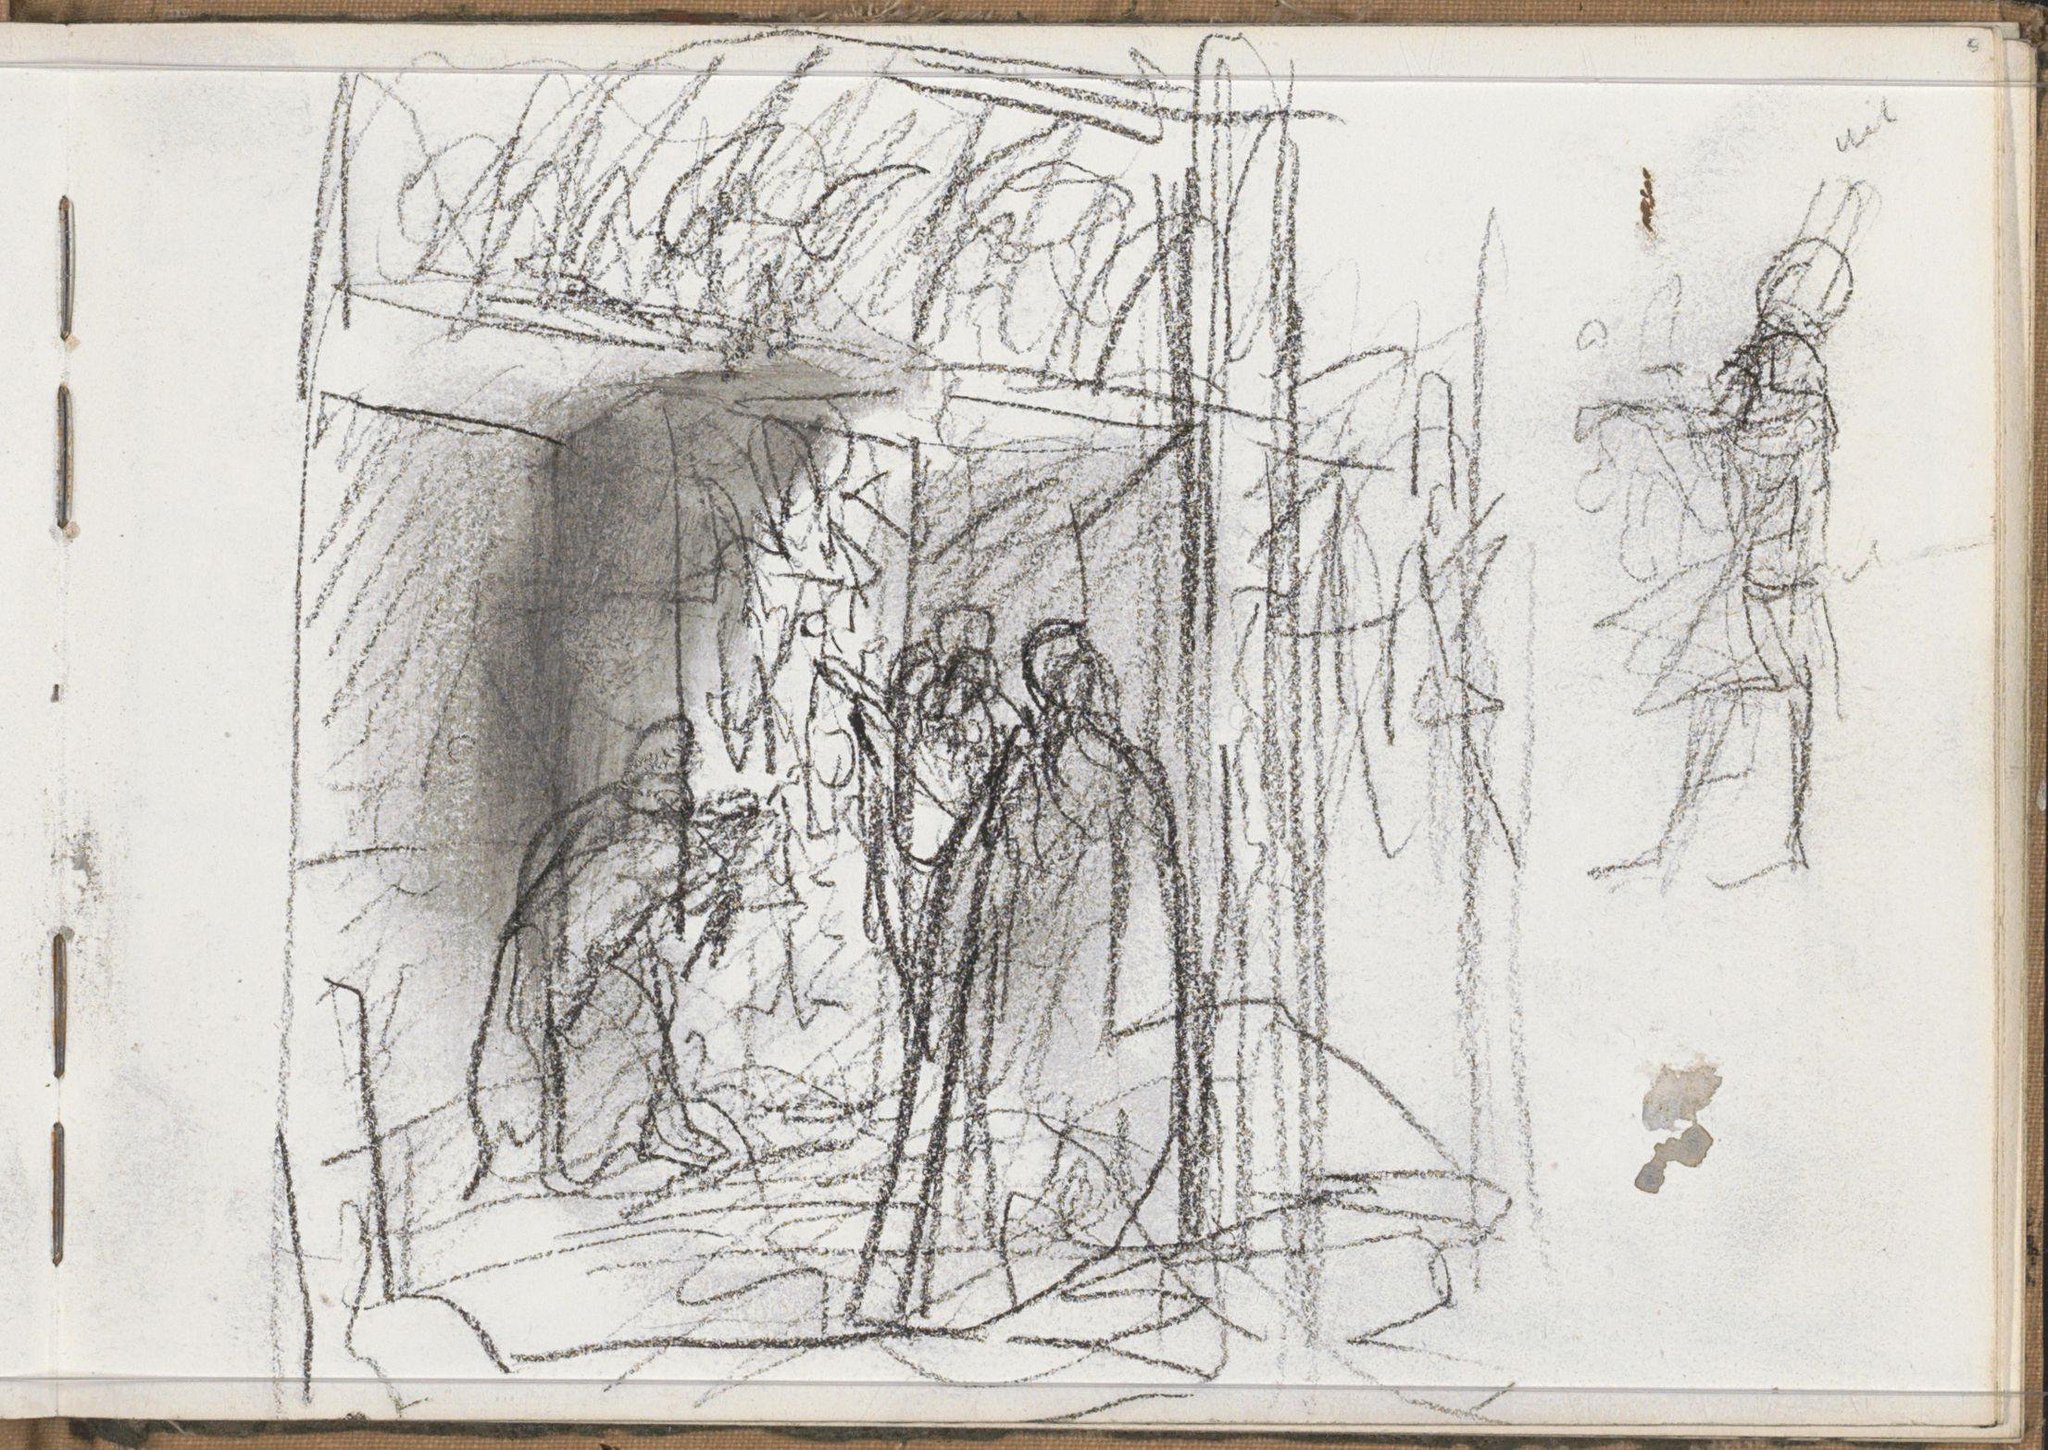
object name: sketchbook leaf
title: Figuren bij de ingang van een tempel of tombe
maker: marius bauer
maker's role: draughtsman, print maker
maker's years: 1867-1932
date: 1919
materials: chalk, paper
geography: egypt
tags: temple, shrine ~ egyptian religion, africans, gate, entrance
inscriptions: kleurnotitie, handgeschreven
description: Tevens een figuurstudie van een Egyptenaar. Pagina 5 uit een schetsboek met 23 bladen.